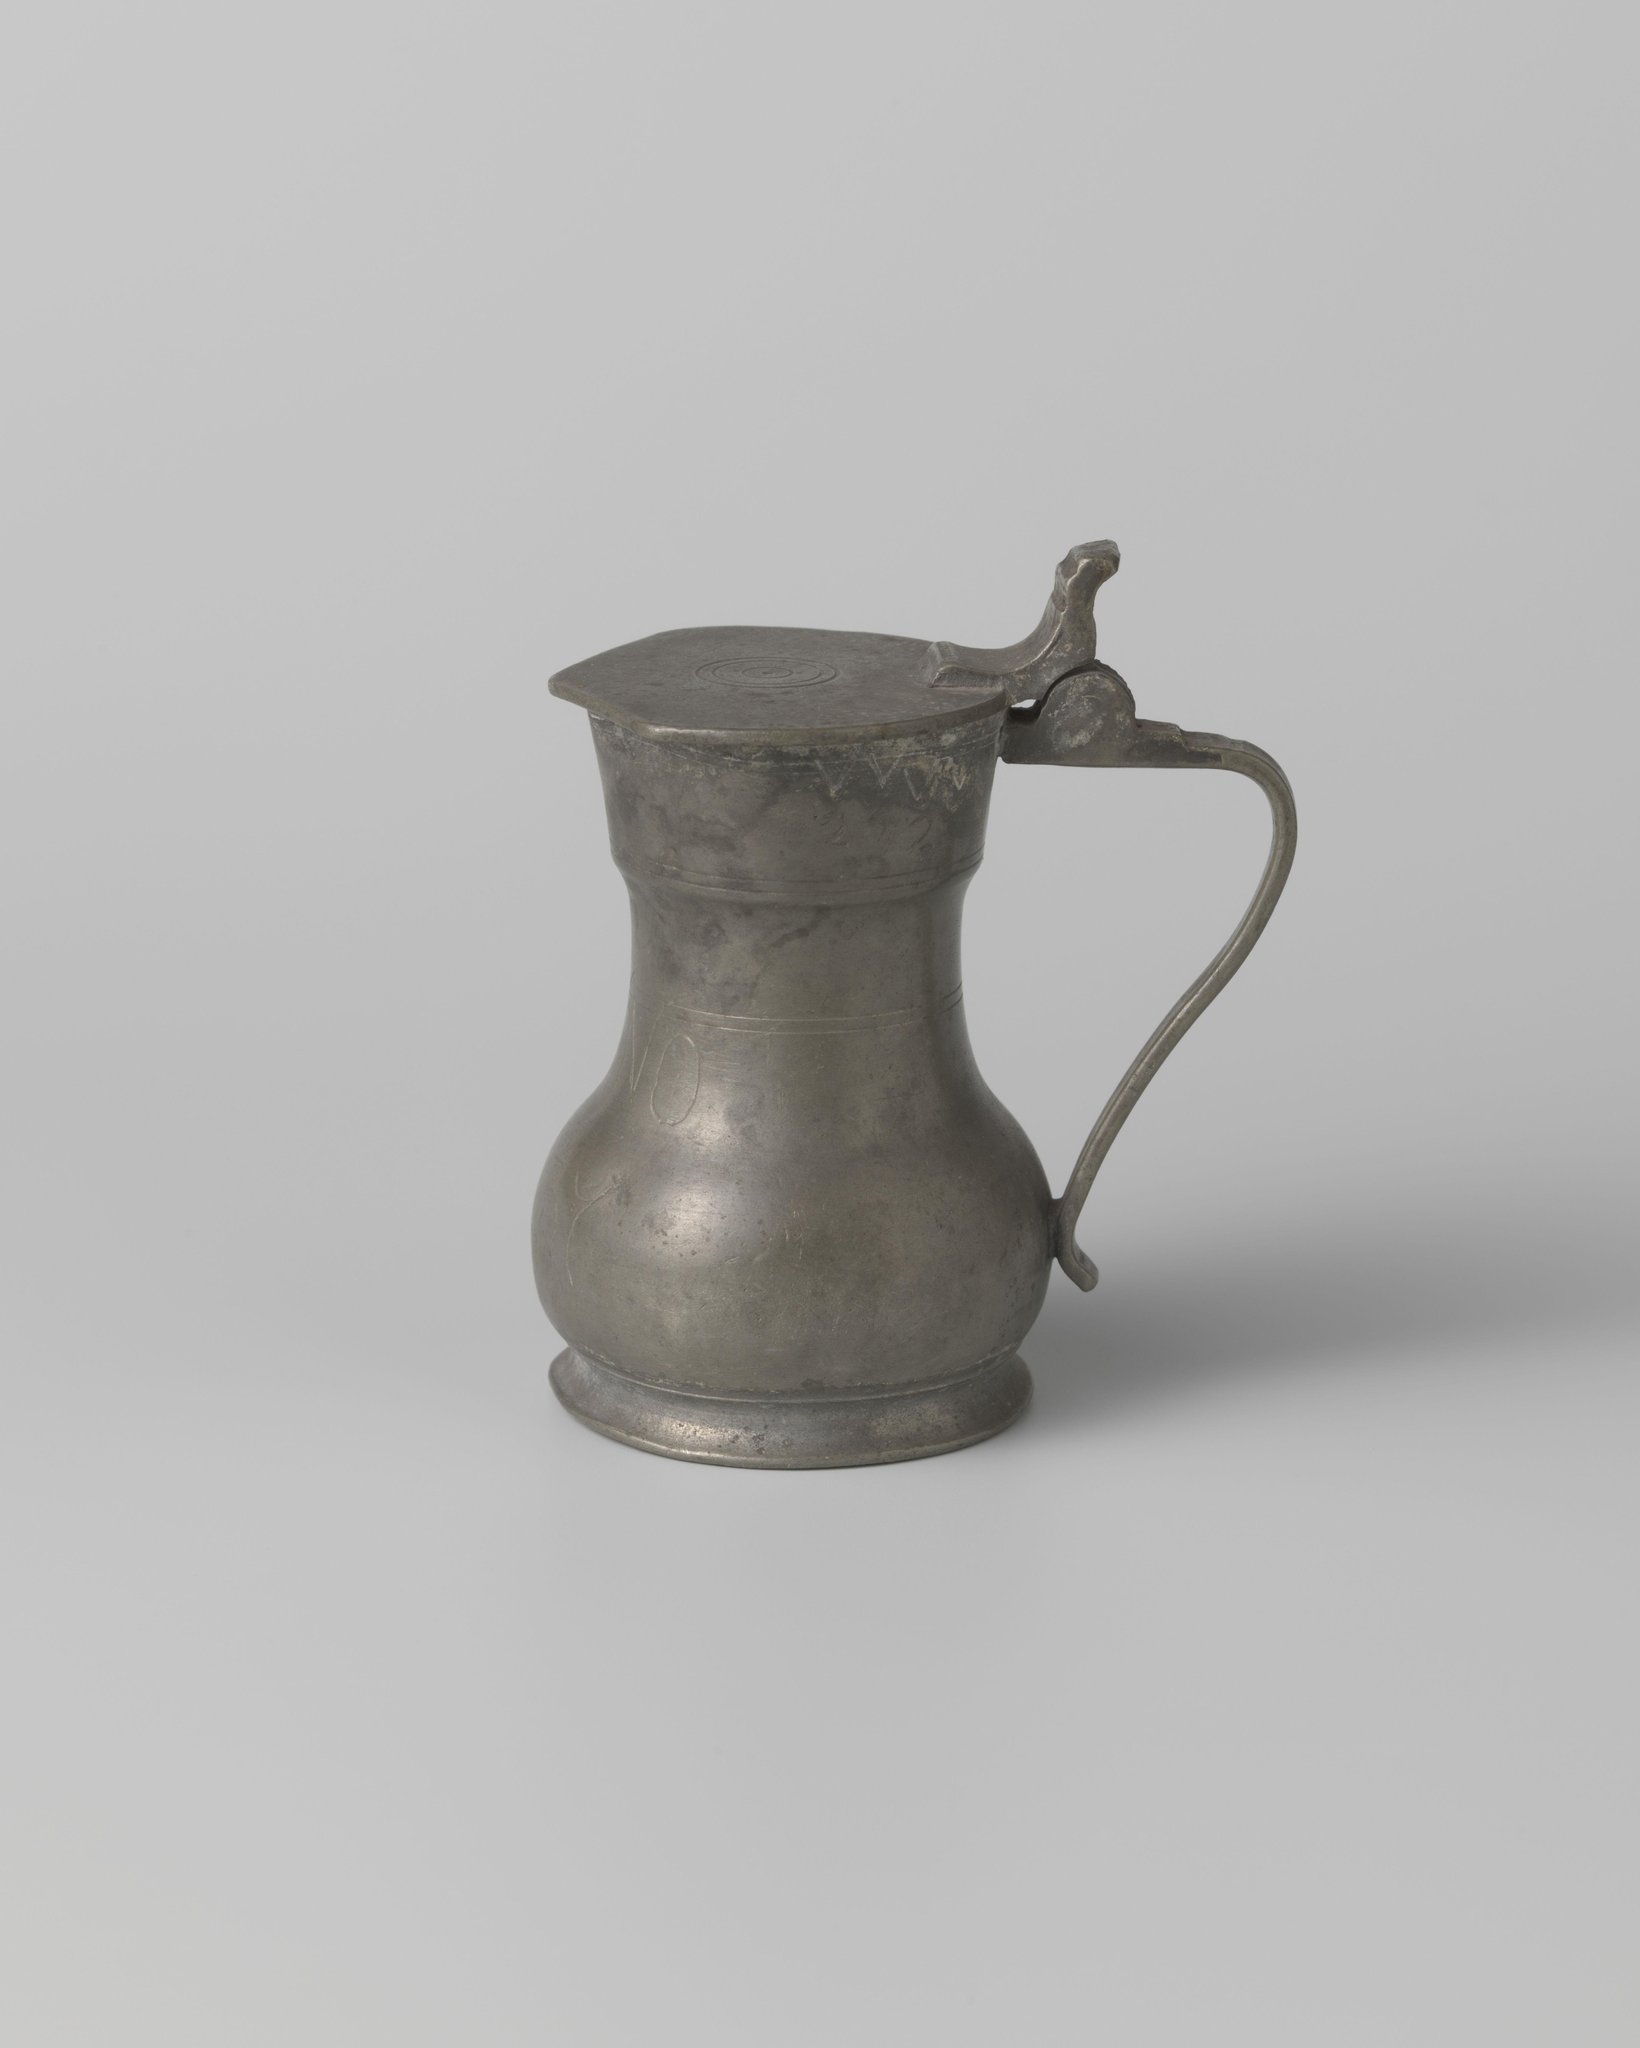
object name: ewer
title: Balustervormige schenkkan van tin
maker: Anonymous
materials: tin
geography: low countries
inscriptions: inscription: ‘ANNO 1637’, quality mark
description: Schenkkan van tin, balustervormig met omgebogen onderrand. De hals eindigt in een brede van voren uitgebogen platte rand. Het platte deksel, gedeeltelijk rond, aan de voorkant hoekig, is door een scharnier aan het rechthoekig gebogen oor bevestigd. Inggrift op het deksel: drie cirkerls, op de buik ANNO 1637 in onbeholpen gravure. Gemerkt op de bodem: gekroond wapen en de letters A.R.....(rest niet leesbaar). Wapen Delft, Maassluis, Brielle ?